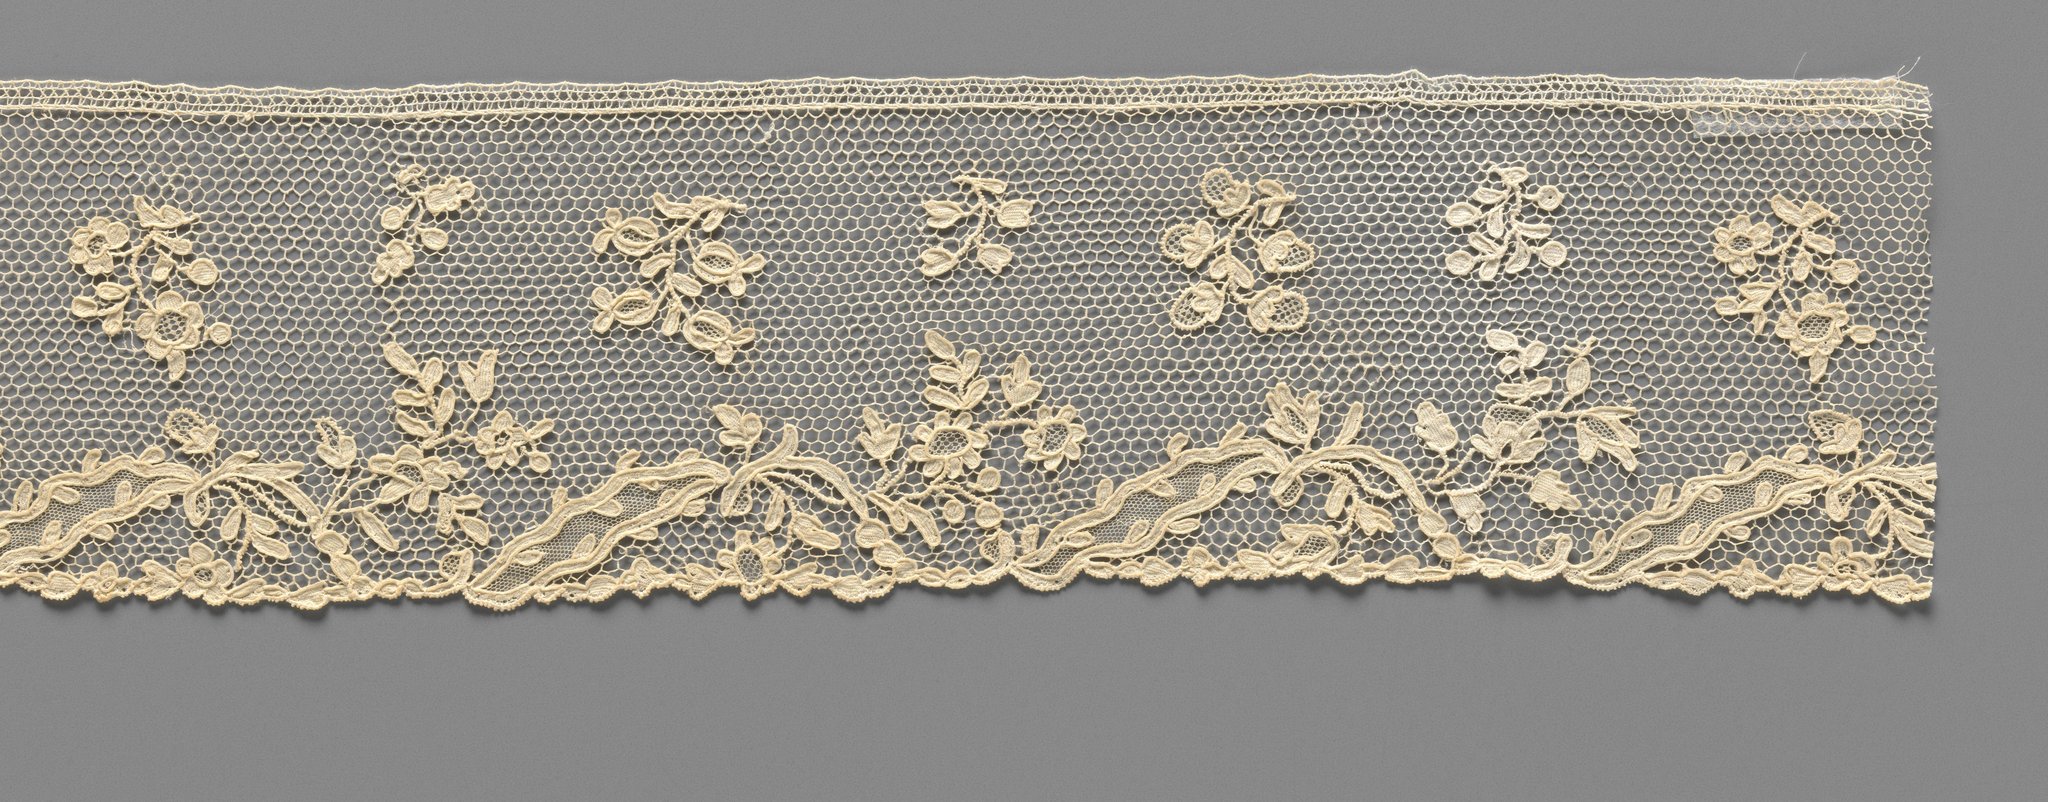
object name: strip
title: Strook naaldkant met aardbeien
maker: Anonymous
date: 1760-1780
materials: lace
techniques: lace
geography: argentan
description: Strook naturelkleurige naaldkant: Argentan-kant. Het zich herhalende patroon bestaat langs de onderste helft van de strook uit een schuin uit de onderzijde ontspringende dubbele tak met een golvende dunnere tak aan het uiteinde waaraan enkele bloemen en bladeren. De bovenste helft van de strook heeft een patroon van losse, naar beneden hangende bloem- en bladertakjes. Aan sommige takjes lijken besjes of aardbeien te hangen. De motieven zijn opgebouwd uit festonsteken en voorzien van reliëfcontouren, die al dan niet zijn voorzien van picots. De motieven zijn met elkaar verbonden door een zeshoekige grond met gefestonneerde mazen. Tussen de dubbele takken is een fijnere maasgrond toegepast als siergrond en in verschillende bloemtakken en in het fruit zijn ook siergrondjes toegepast. De vlakke schulpenrand komt voort uit vele kleine motiefjes die langs de onderzijde van de strook liggen en die zijn afgewerkt met picots. De bovenzijde is recht afgewerkt met een geklost bandje.